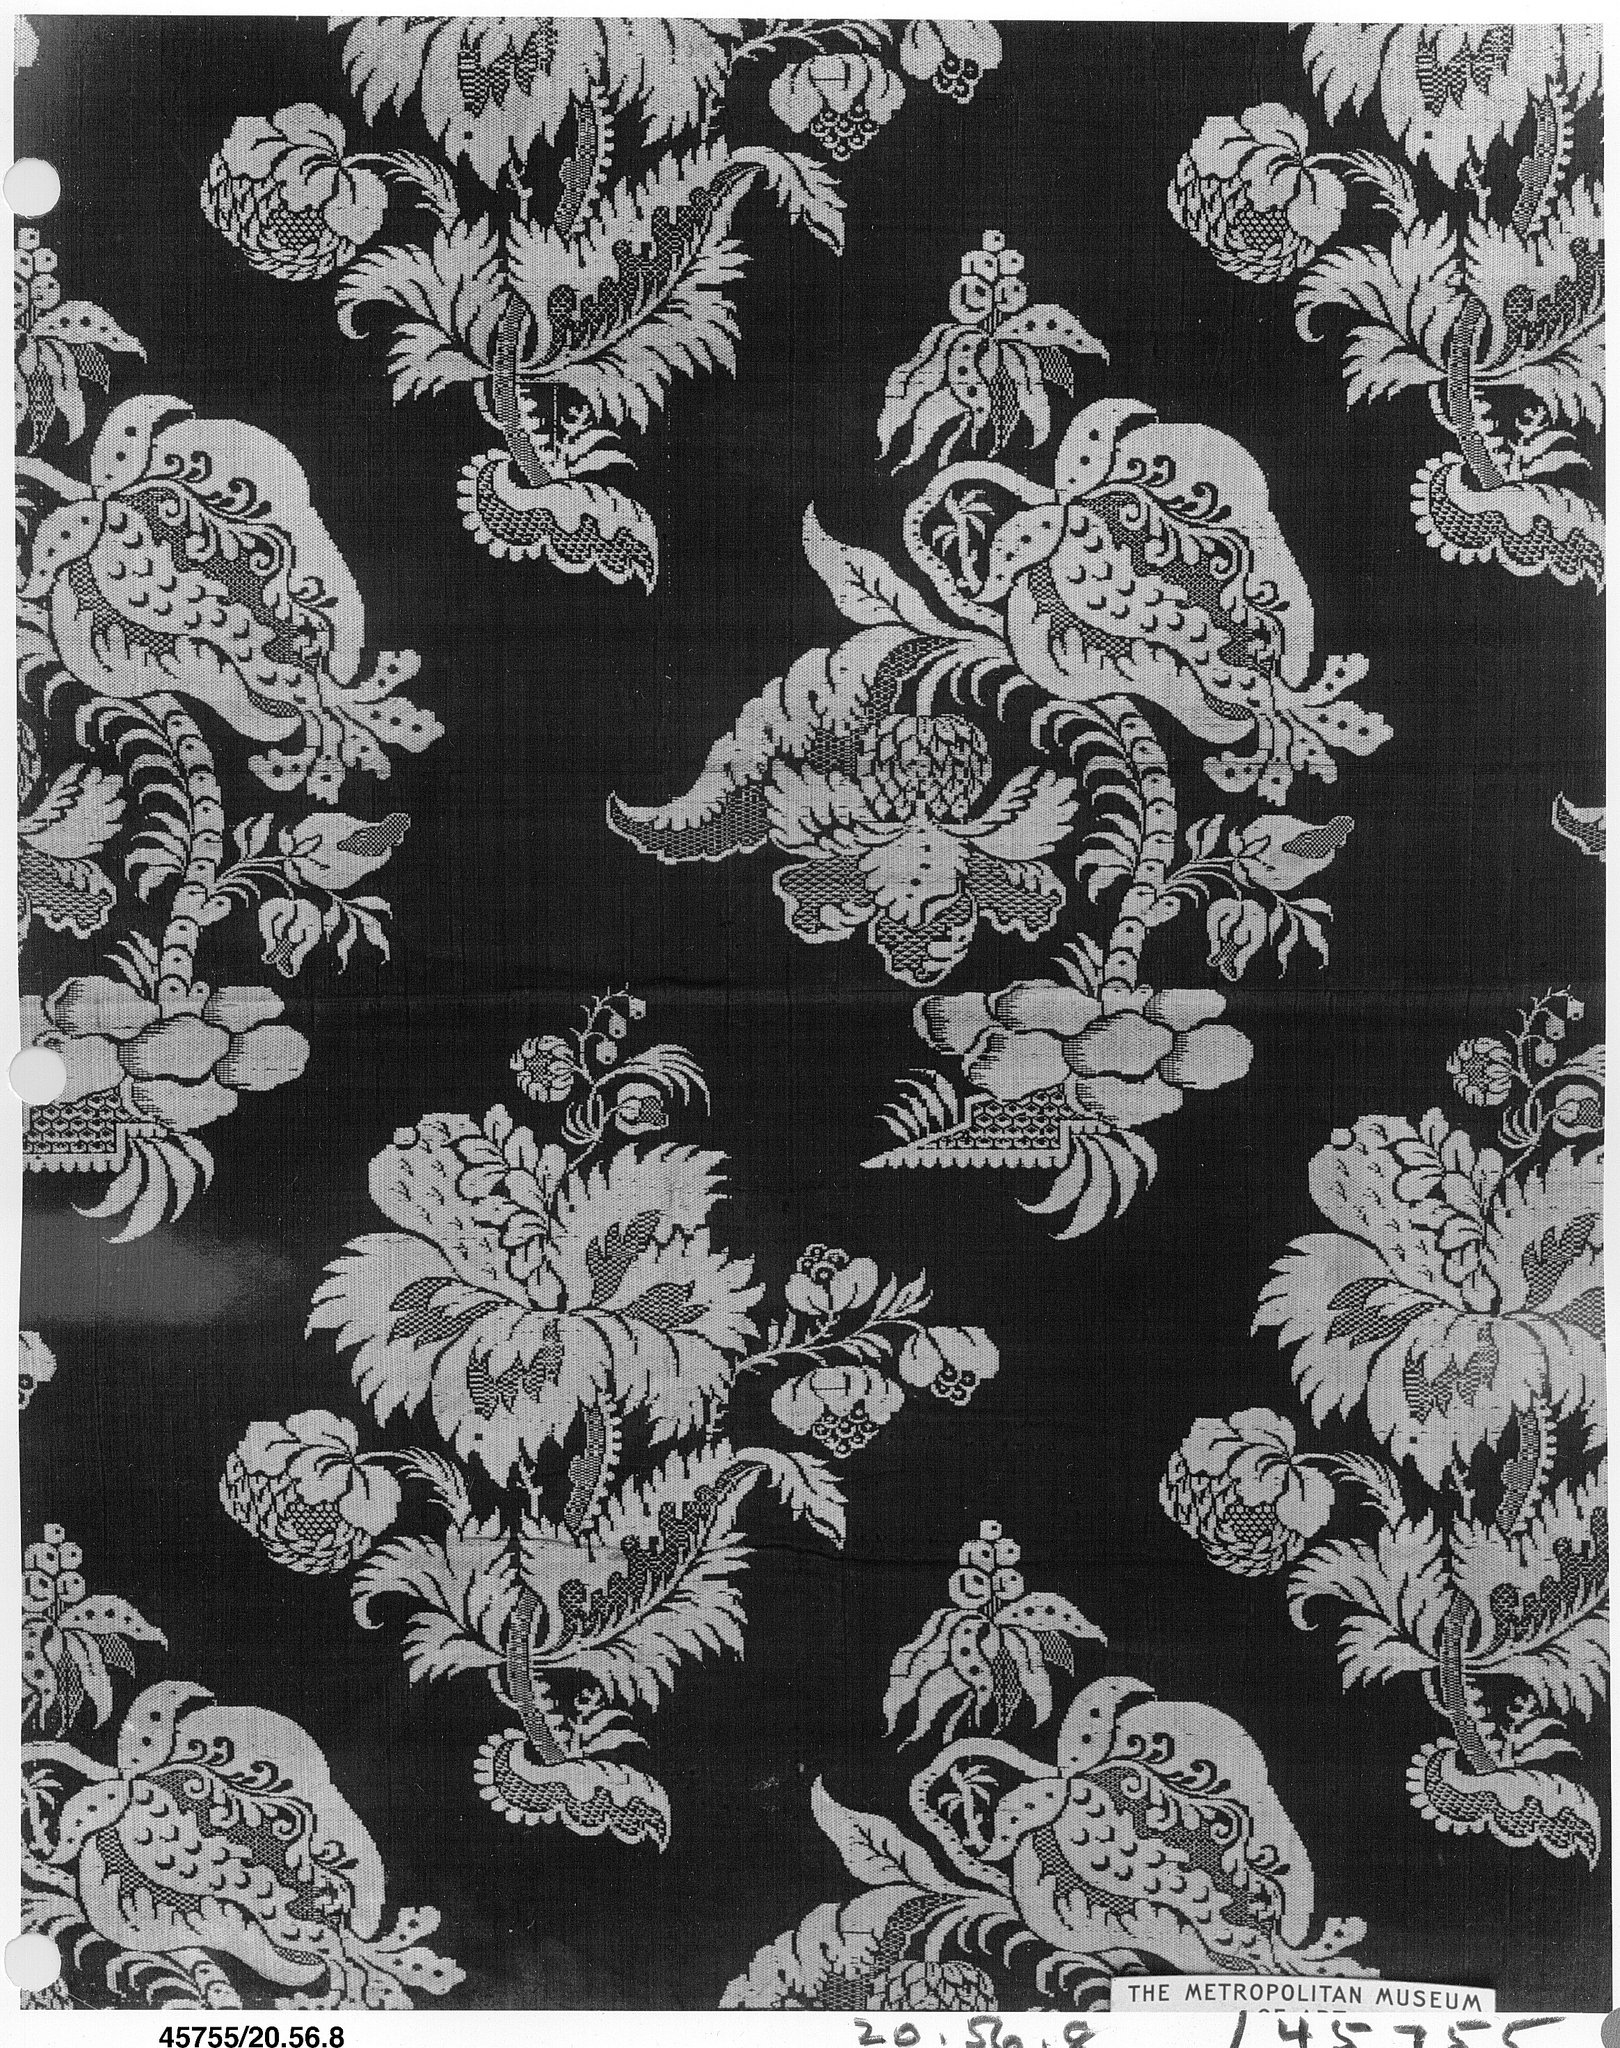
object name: piece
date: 1735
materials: silk